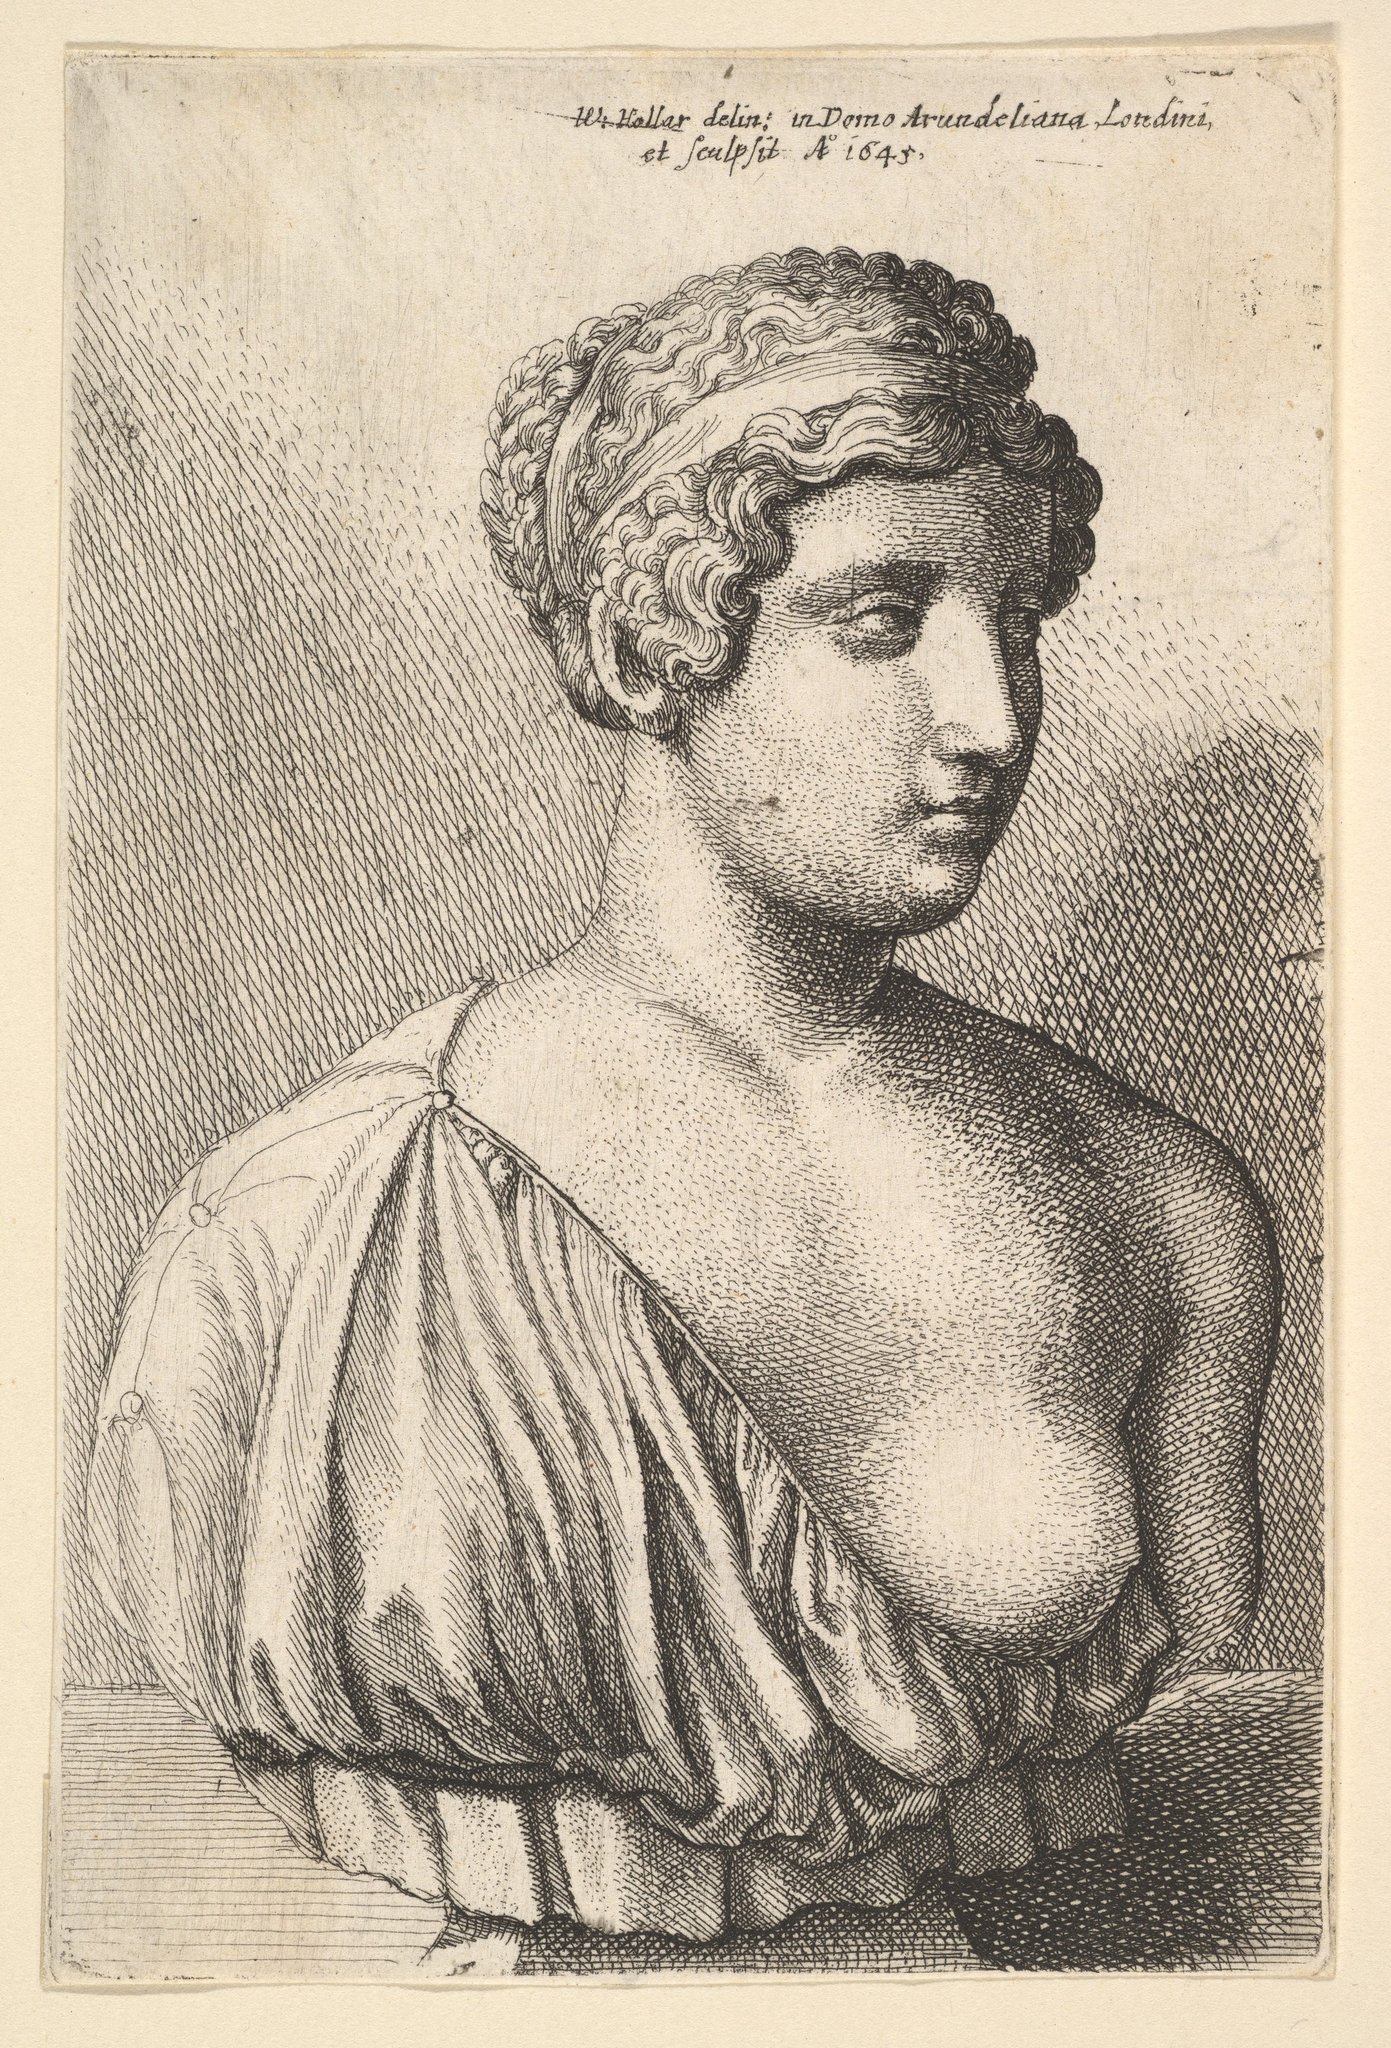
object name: print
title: Antique bust of a woman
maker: wenceslaus hollar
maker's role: artist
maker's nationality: bohemian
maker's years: 1607-1677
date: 1645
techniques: etching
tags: portraits,women,female nudes